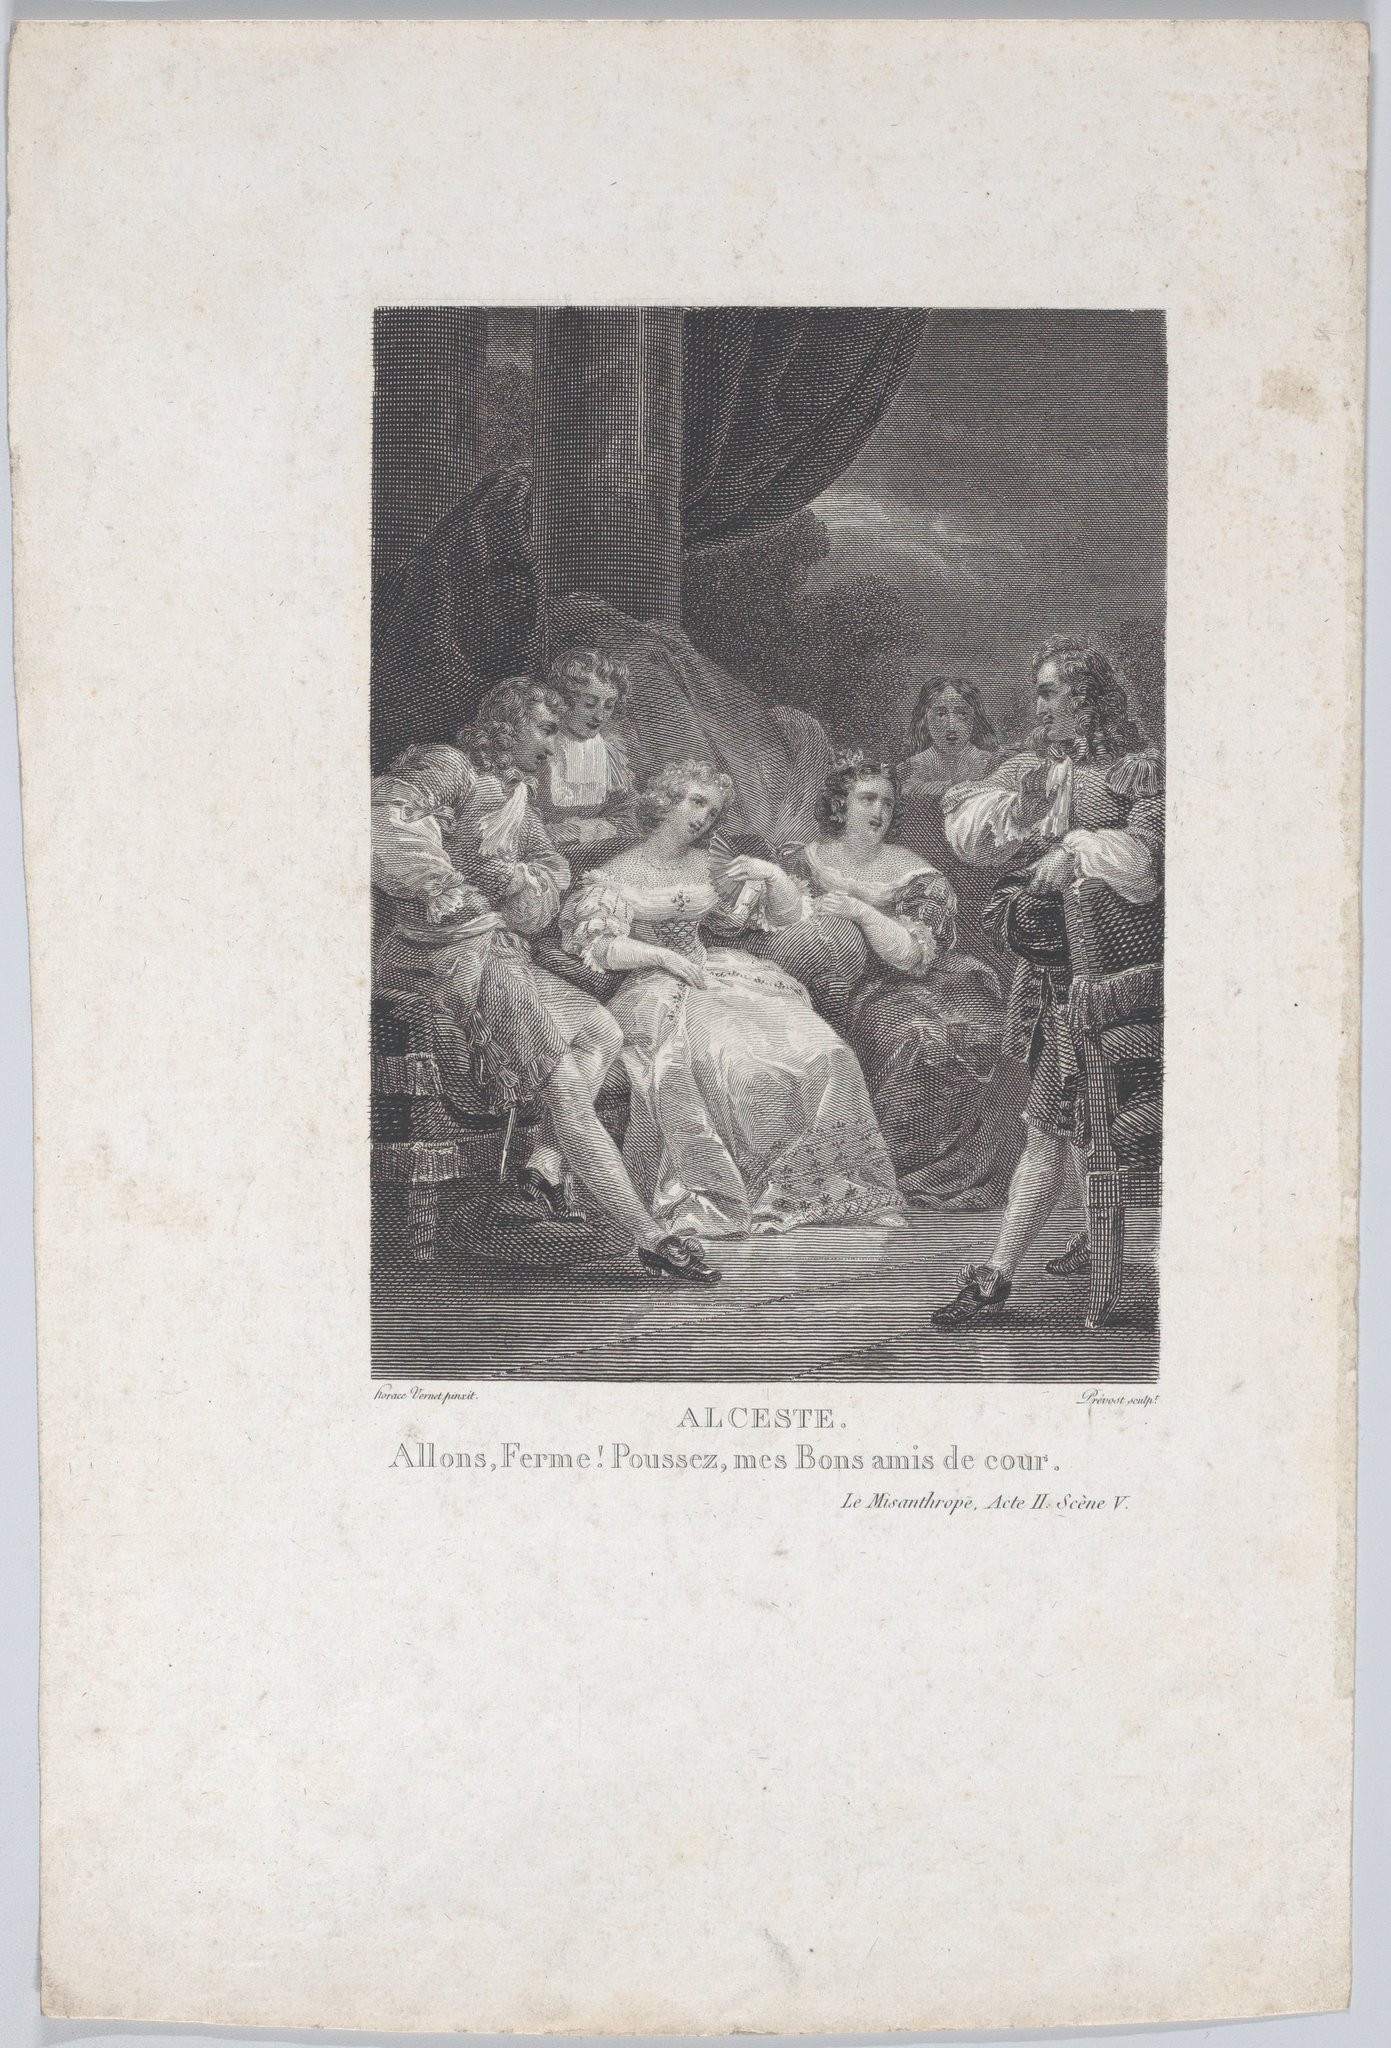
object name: print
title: Alceste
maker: horace vernet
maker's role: artist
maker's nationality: french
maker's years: 1789-1863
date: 1840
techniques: engraving